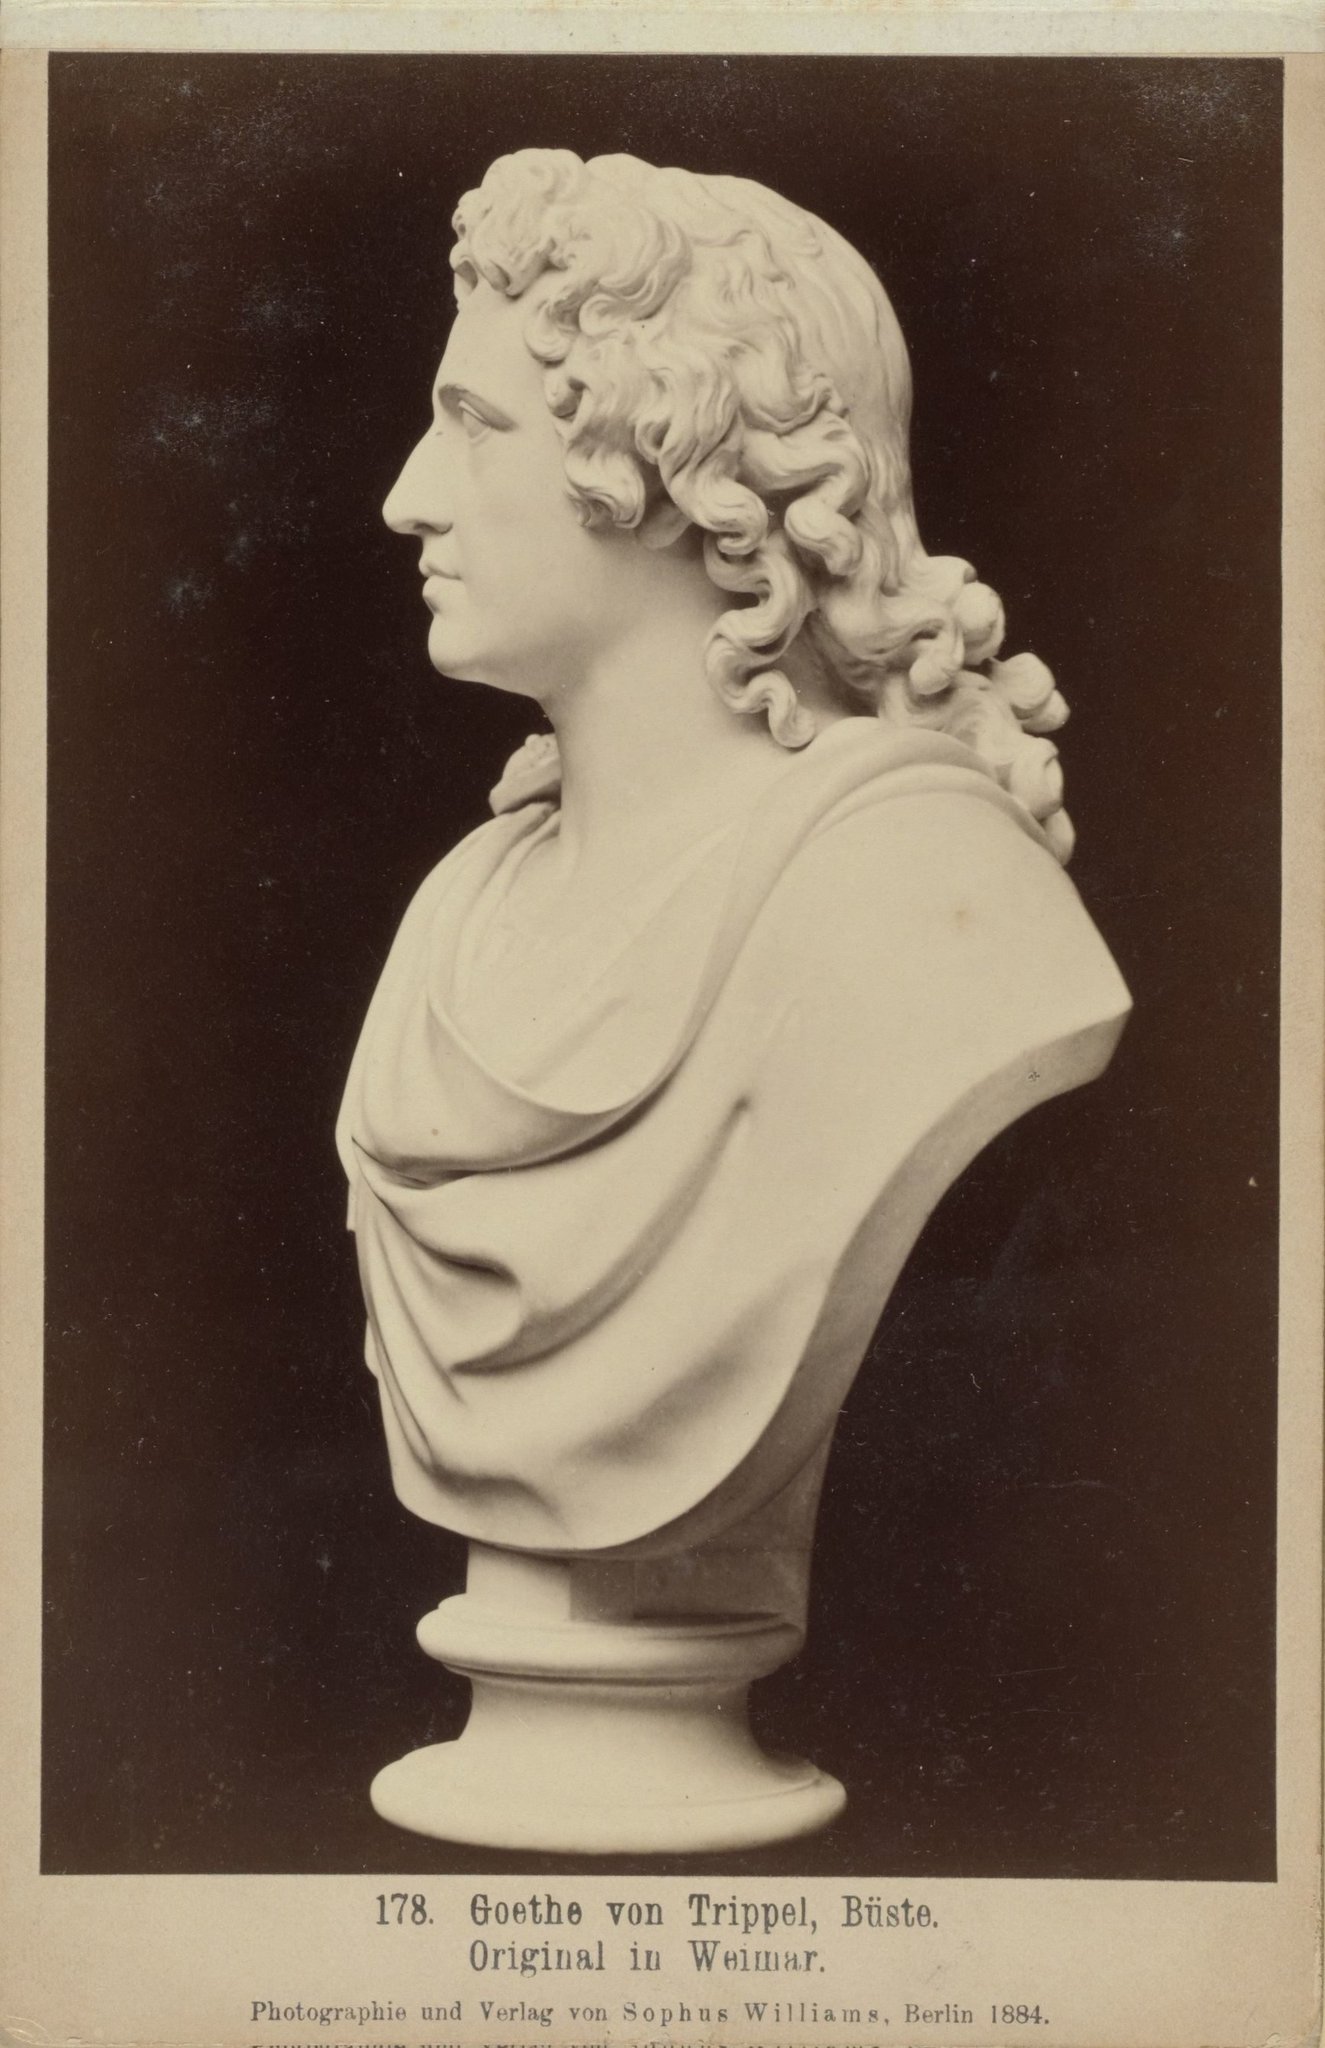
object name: cabinet photograph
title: Goethe von Trippel, Buste. Original in Weimar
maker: sophus williams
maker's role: publisher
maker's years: 1835-1900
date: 1884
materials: cardboard, paper, photographic support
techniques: albumen print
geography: germany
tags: draughtsman, johann wolfgang von goethe, piece of sculpture, reproduction of a piece of sculpture, travelling; tourism, germany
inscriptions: number: ‘178’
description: Onderdeel van Album met 38 foto's van een reis door de Harz.